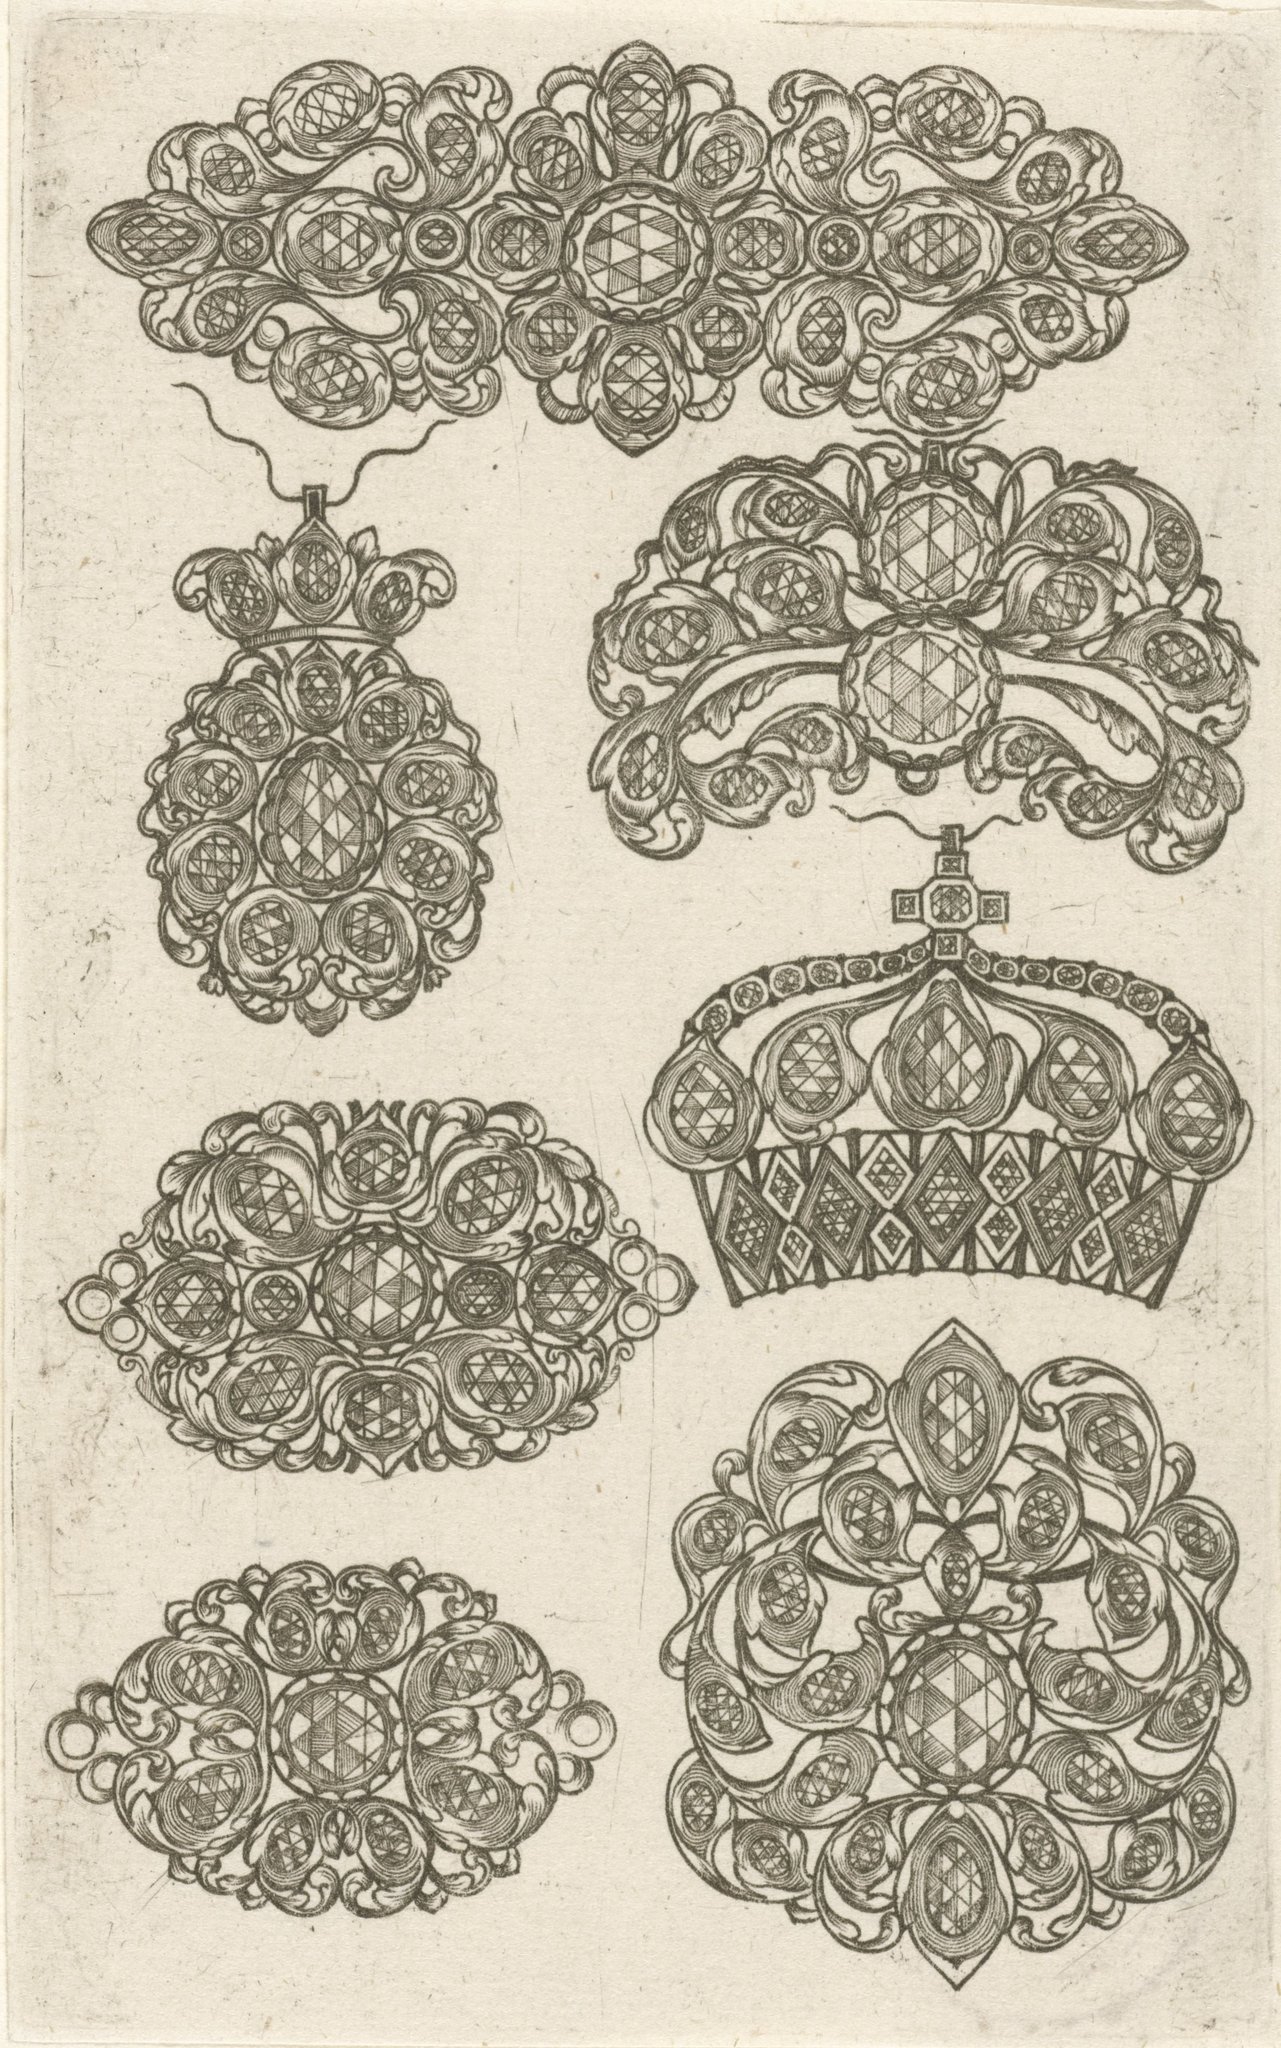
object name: ornament print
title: Nieuwigheden van de Goutsmeeding (...)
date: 1600-1699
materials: paper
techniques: engraving, etching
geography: netherlands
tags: hare-hunting, rabbit-hunting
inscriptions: collector's mark: Lugt 240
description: Ontwerpen voor onder andere hangers en een gesp. Uit serie bestaande uit een titelblad en 9 bladen.